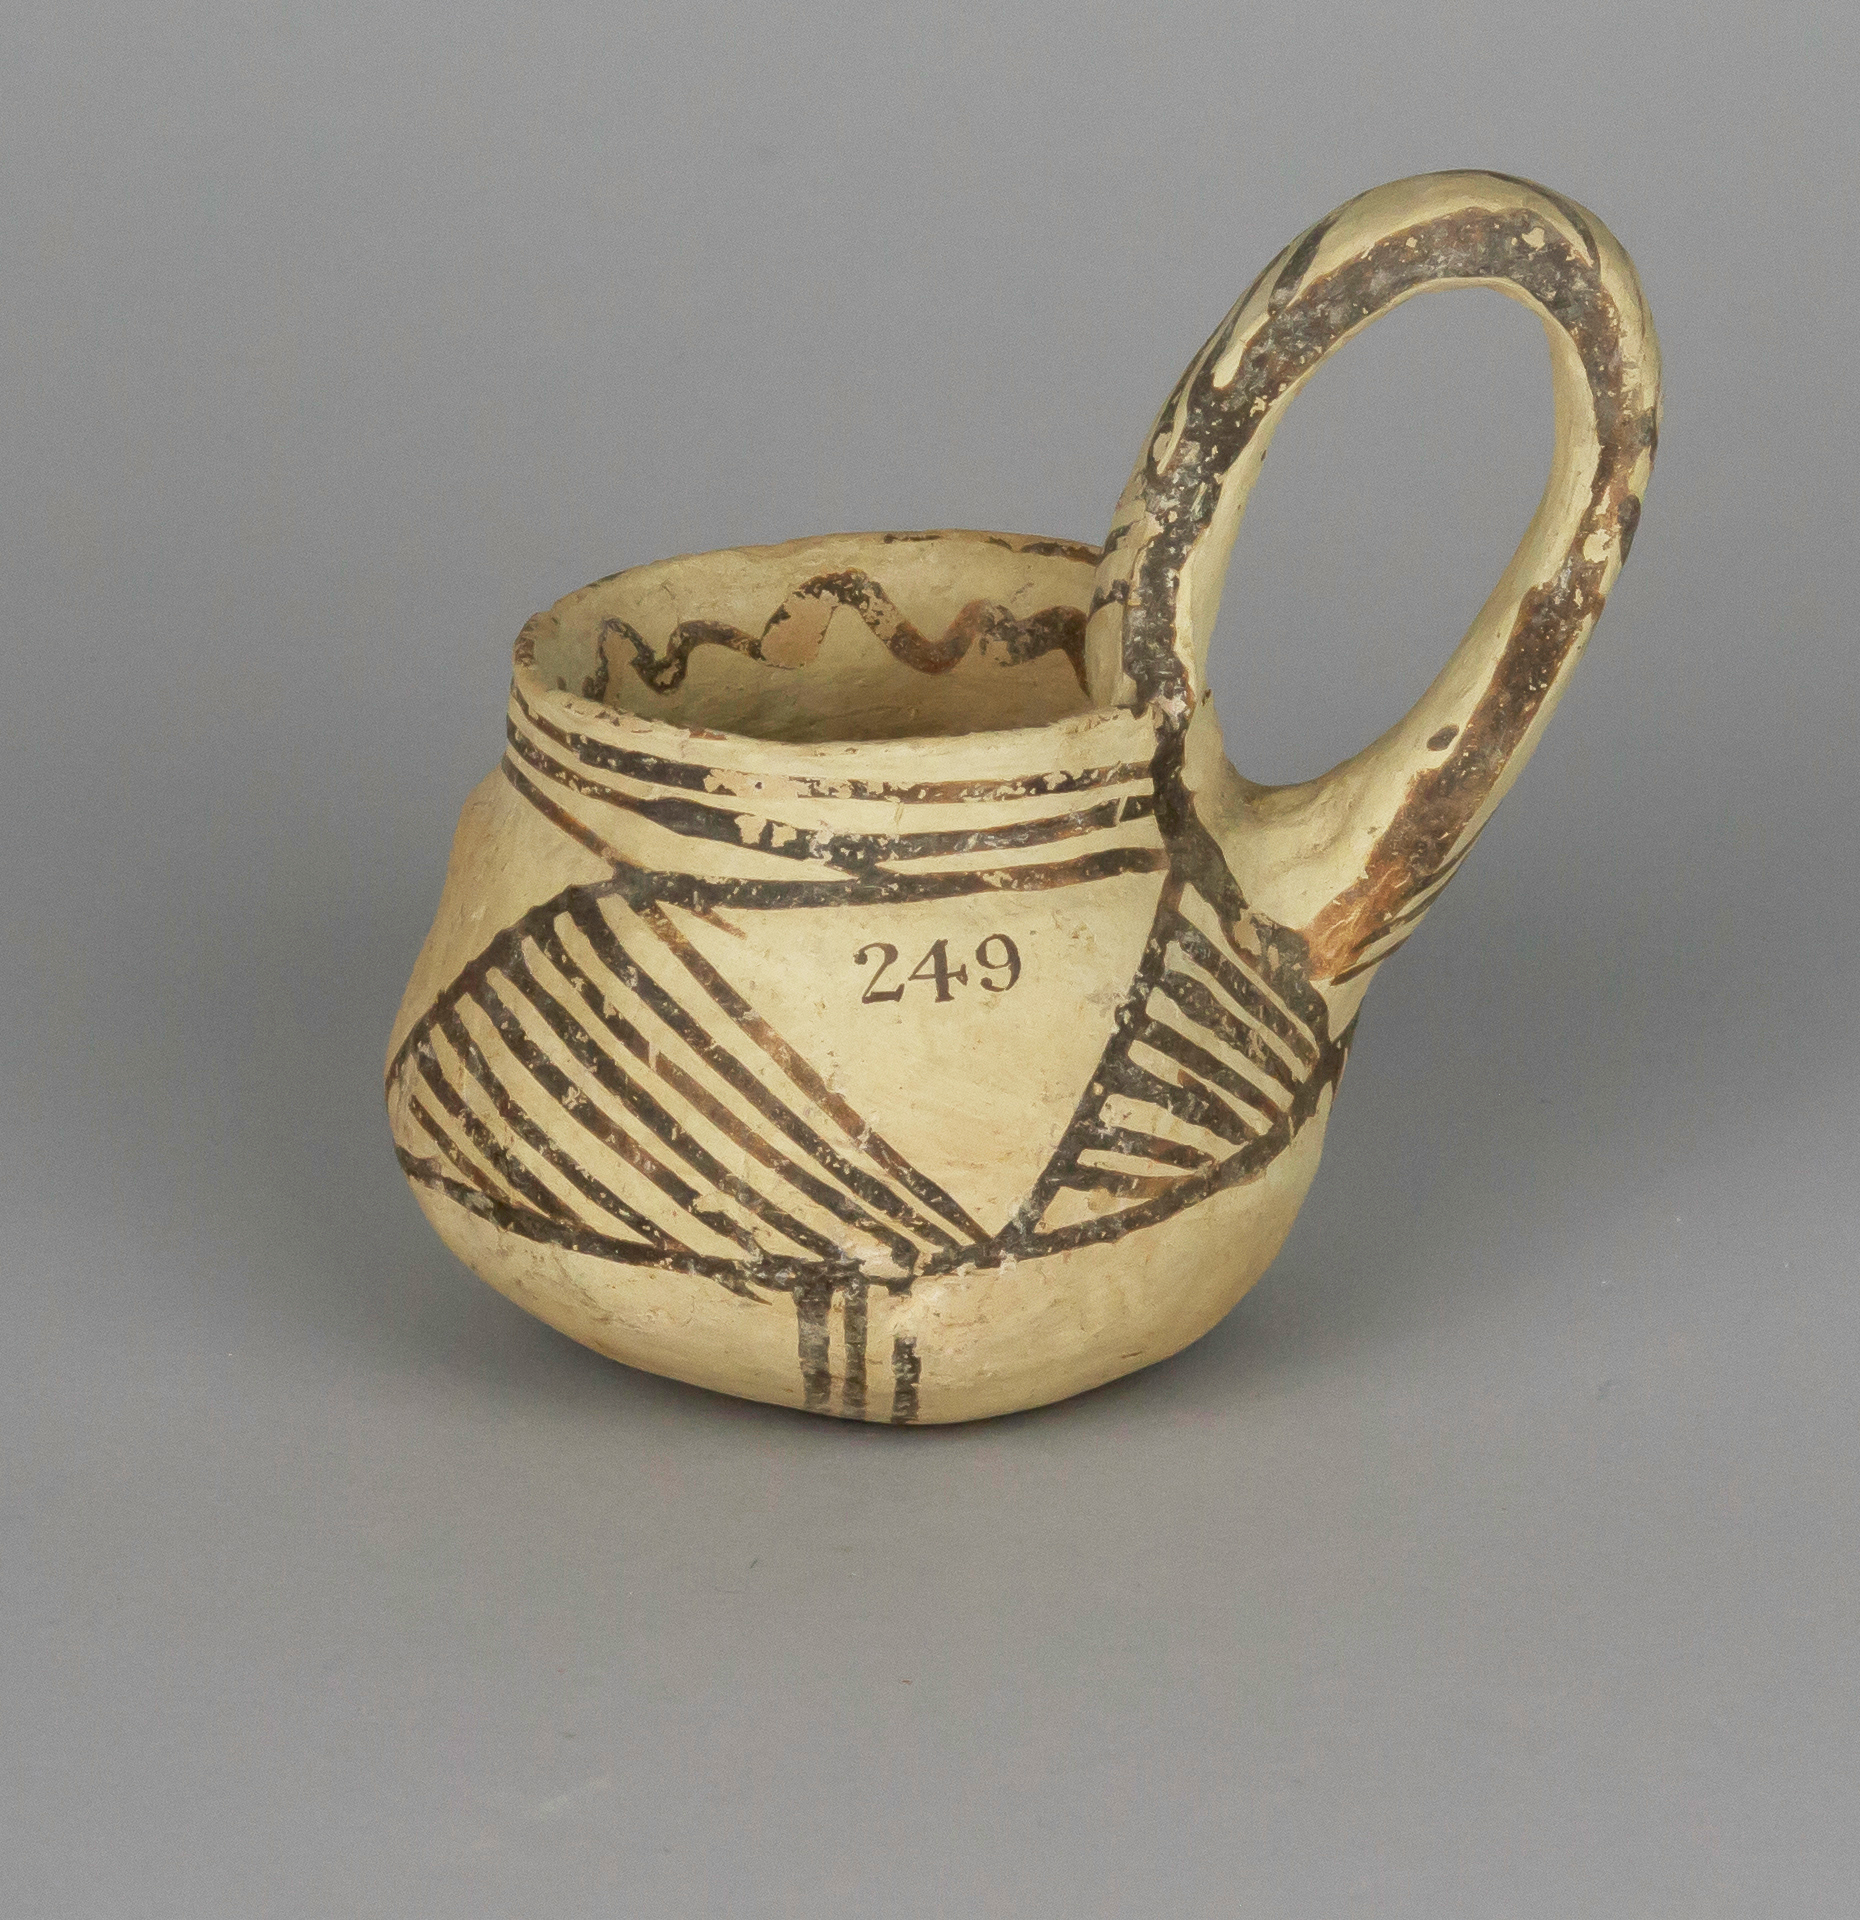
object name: cup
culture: cypriot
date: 3200-1050 BCE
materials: terracotta